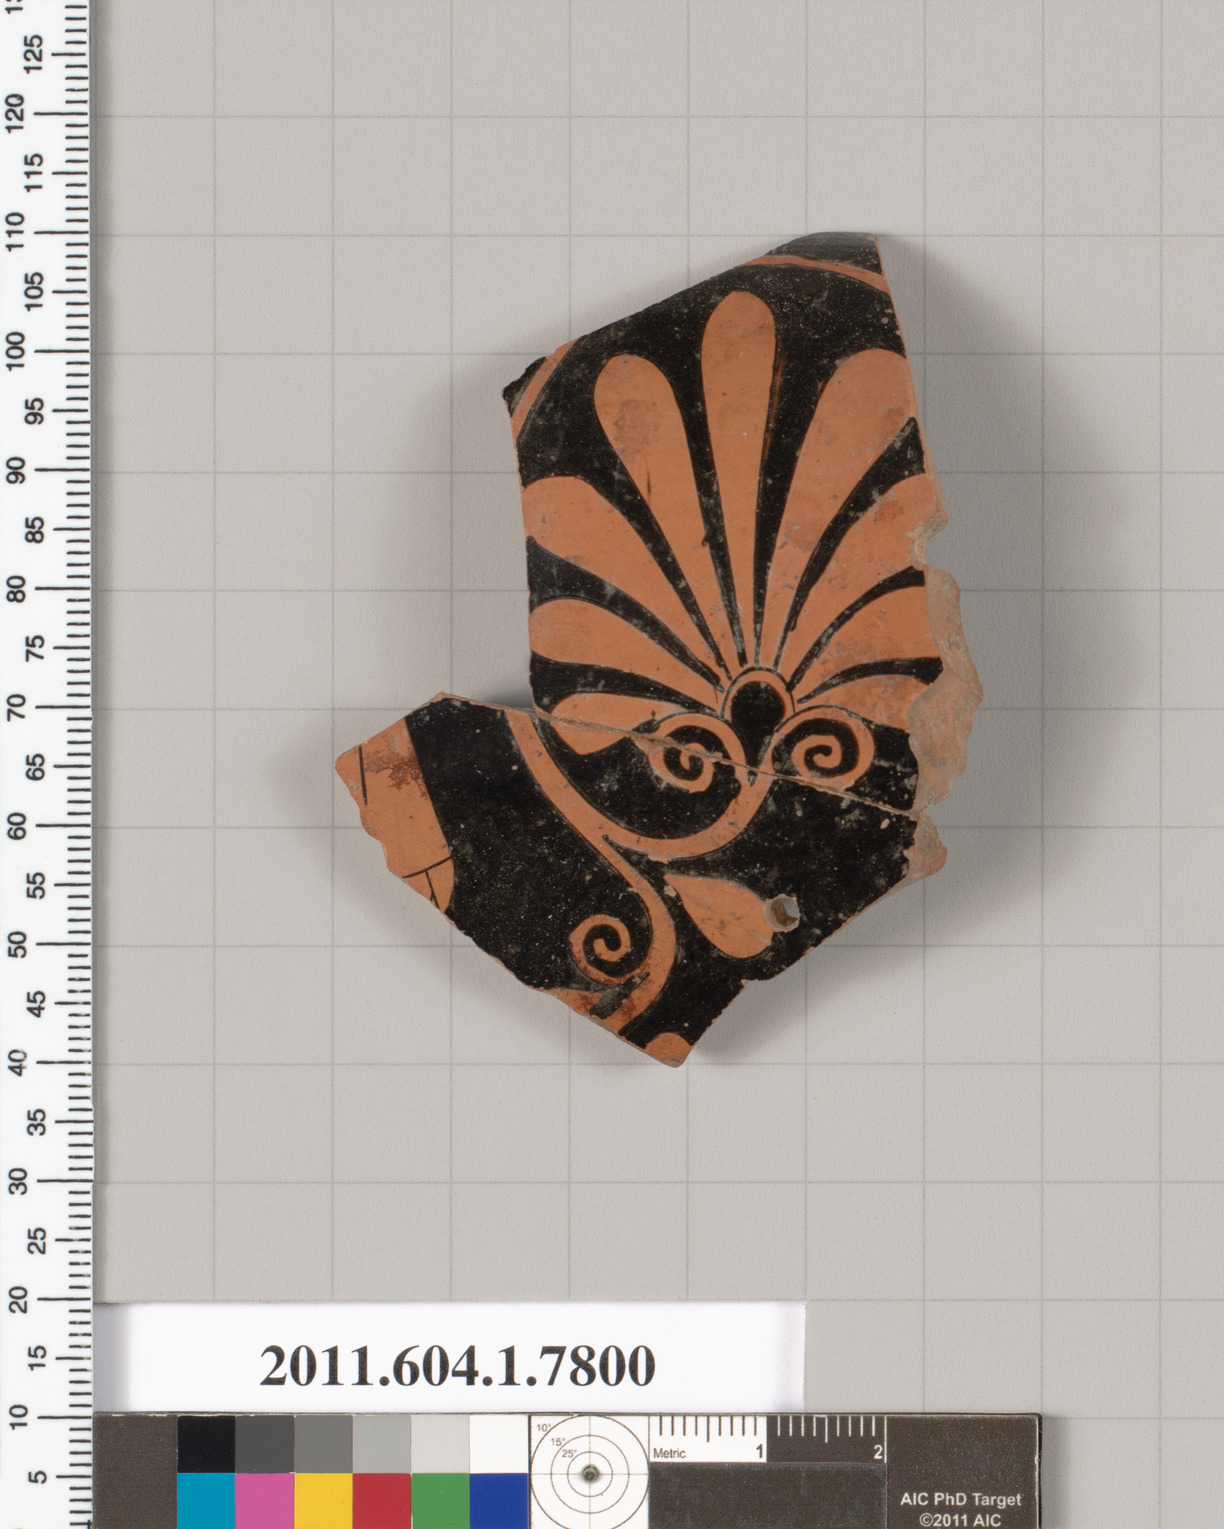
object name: kylix fragment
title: Terracotta rim fragment of a kylix (drinking cup)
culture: greek, attic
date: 460-450 BCE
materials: terracotta